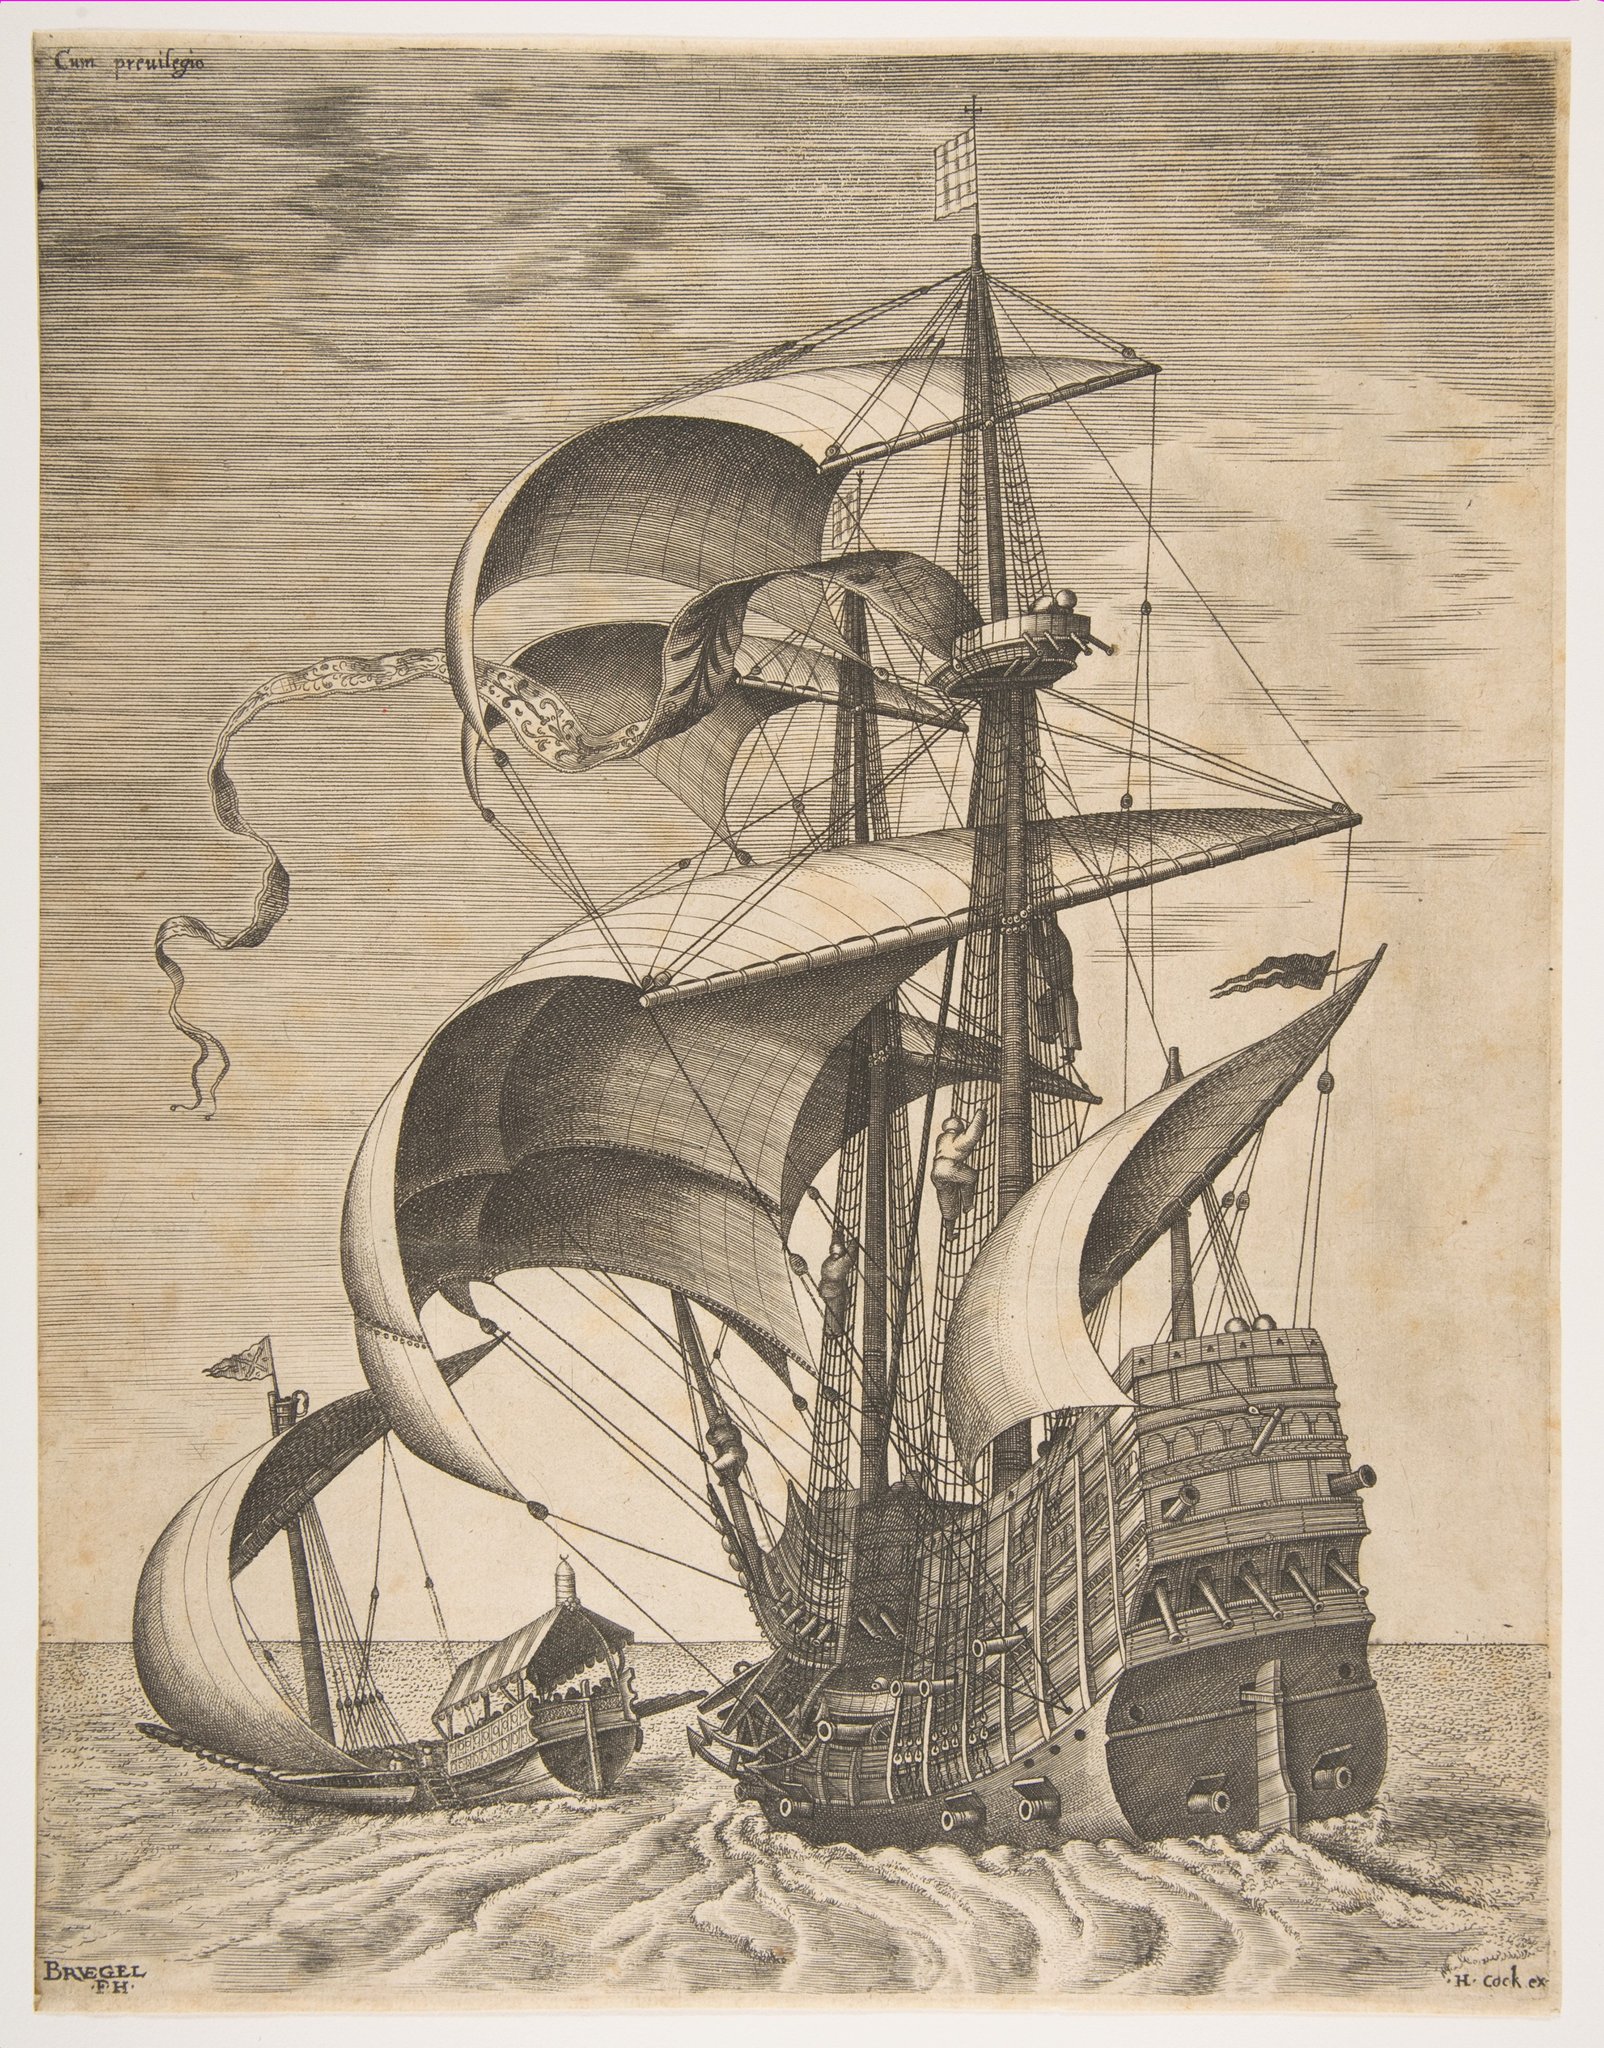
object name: print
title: Armed Three-Master on the Open Sea Accompanied by a Galley, from the series Sailing Vessels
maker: pieter bruegel the elder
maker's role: artist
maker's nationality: netherlandish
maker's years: 1525-1569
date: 1561-1565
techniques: engraving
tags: ships